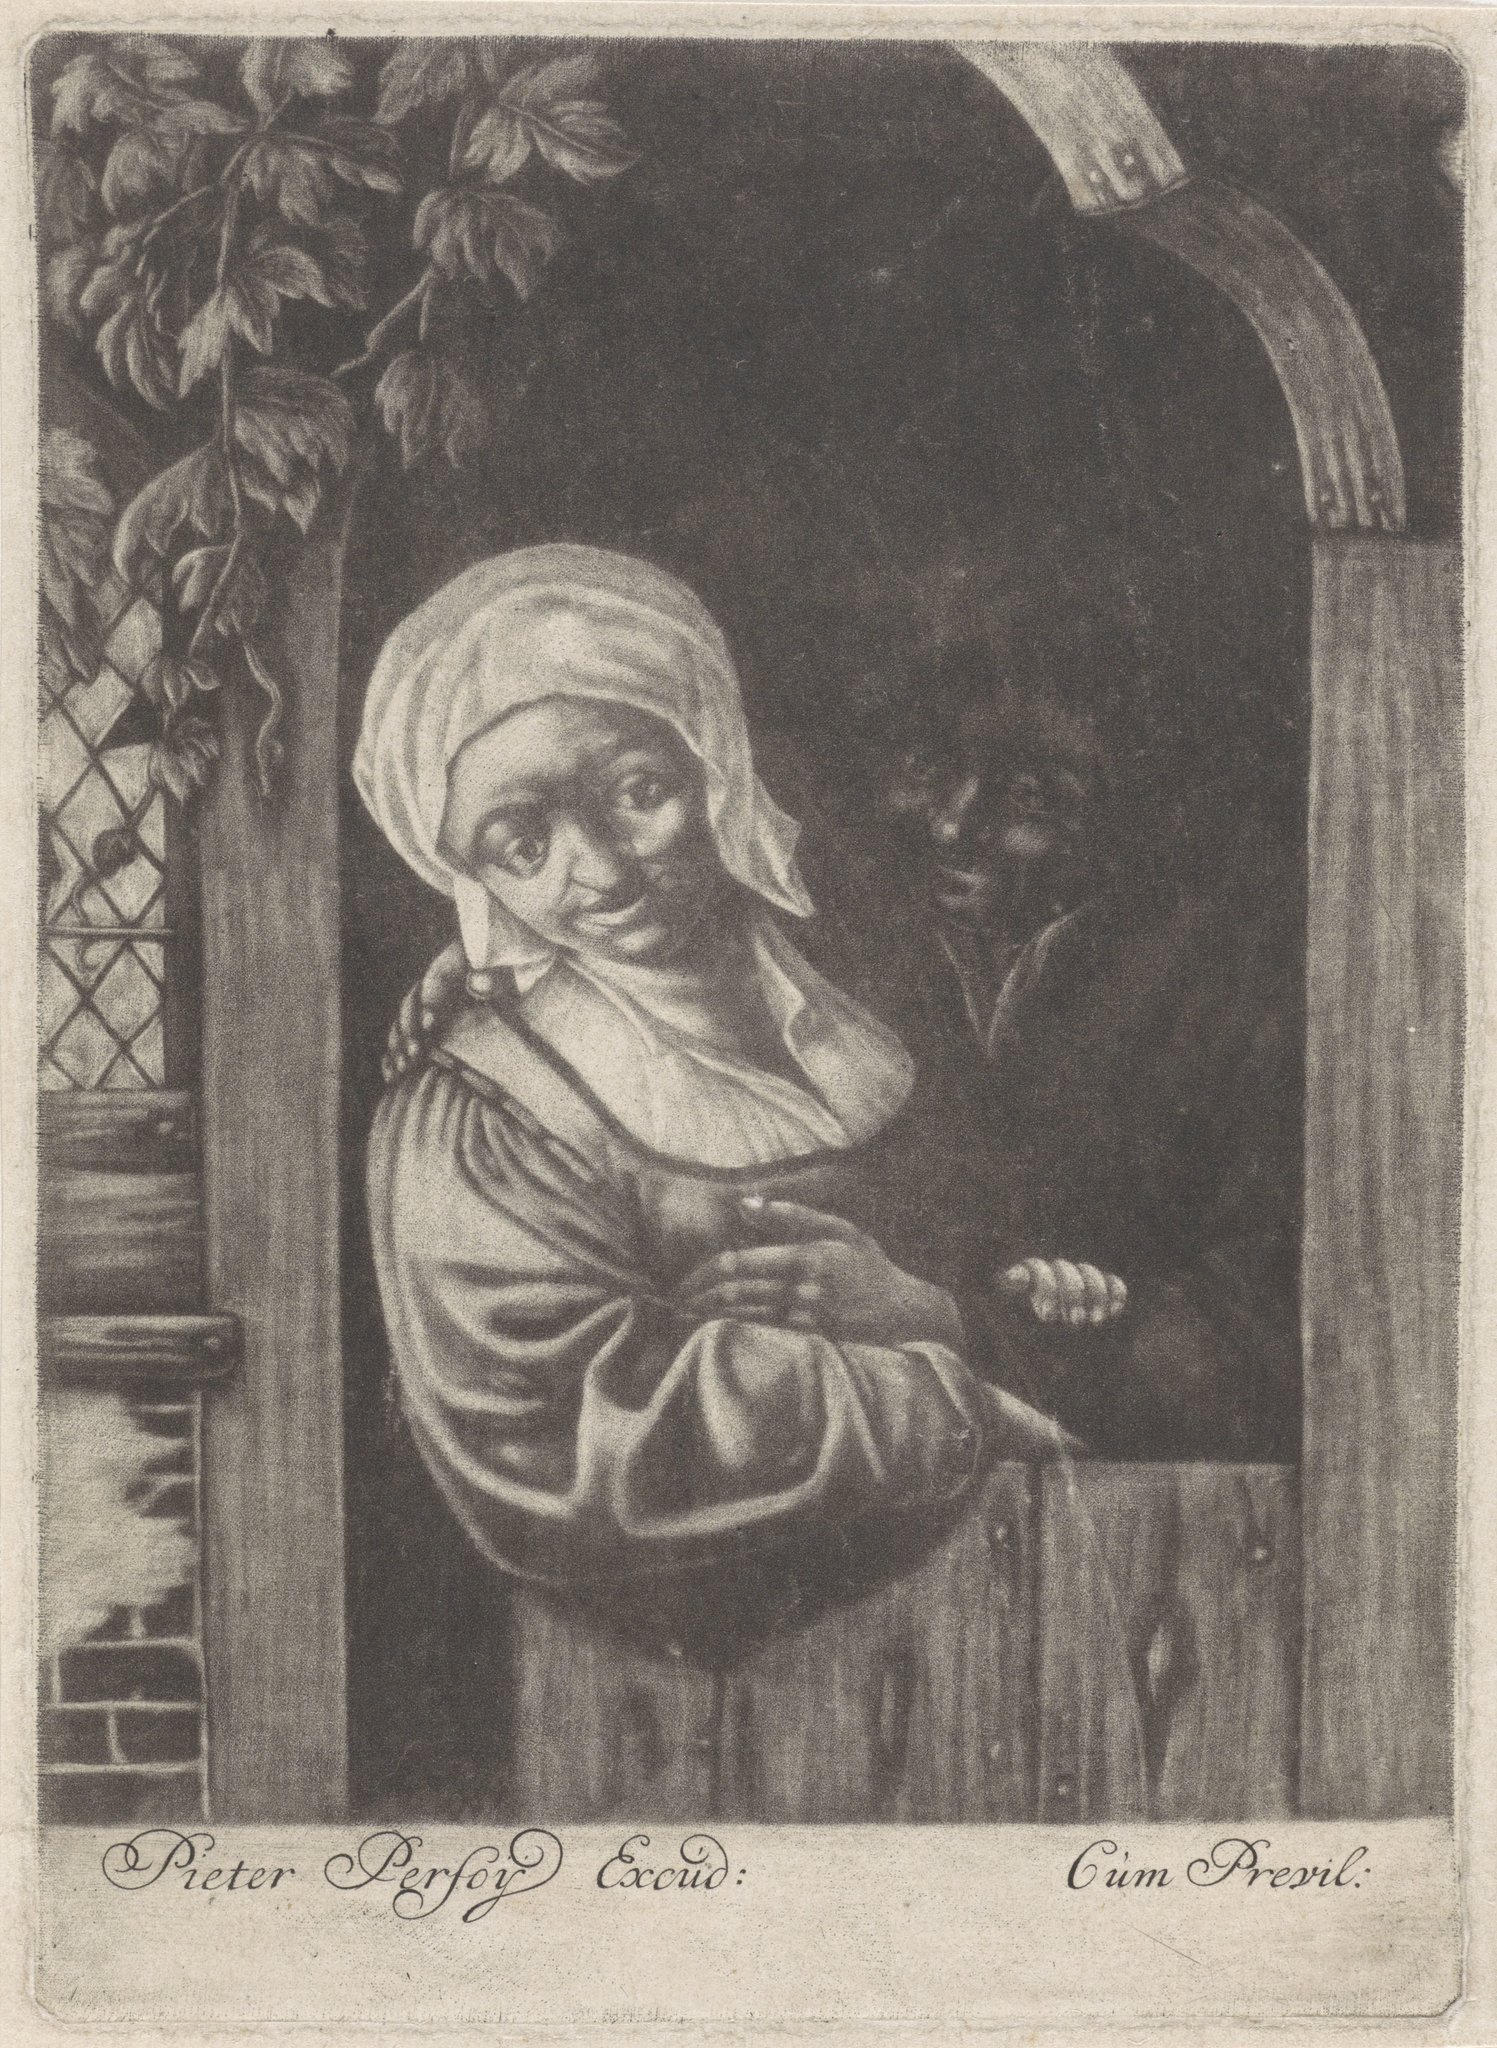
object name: print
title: Man en vrouw in een deuropening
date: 1688-1694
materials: paper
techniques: mezzotint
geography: northern netherlands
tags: open door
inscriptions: collector's mark: Lugt 2228